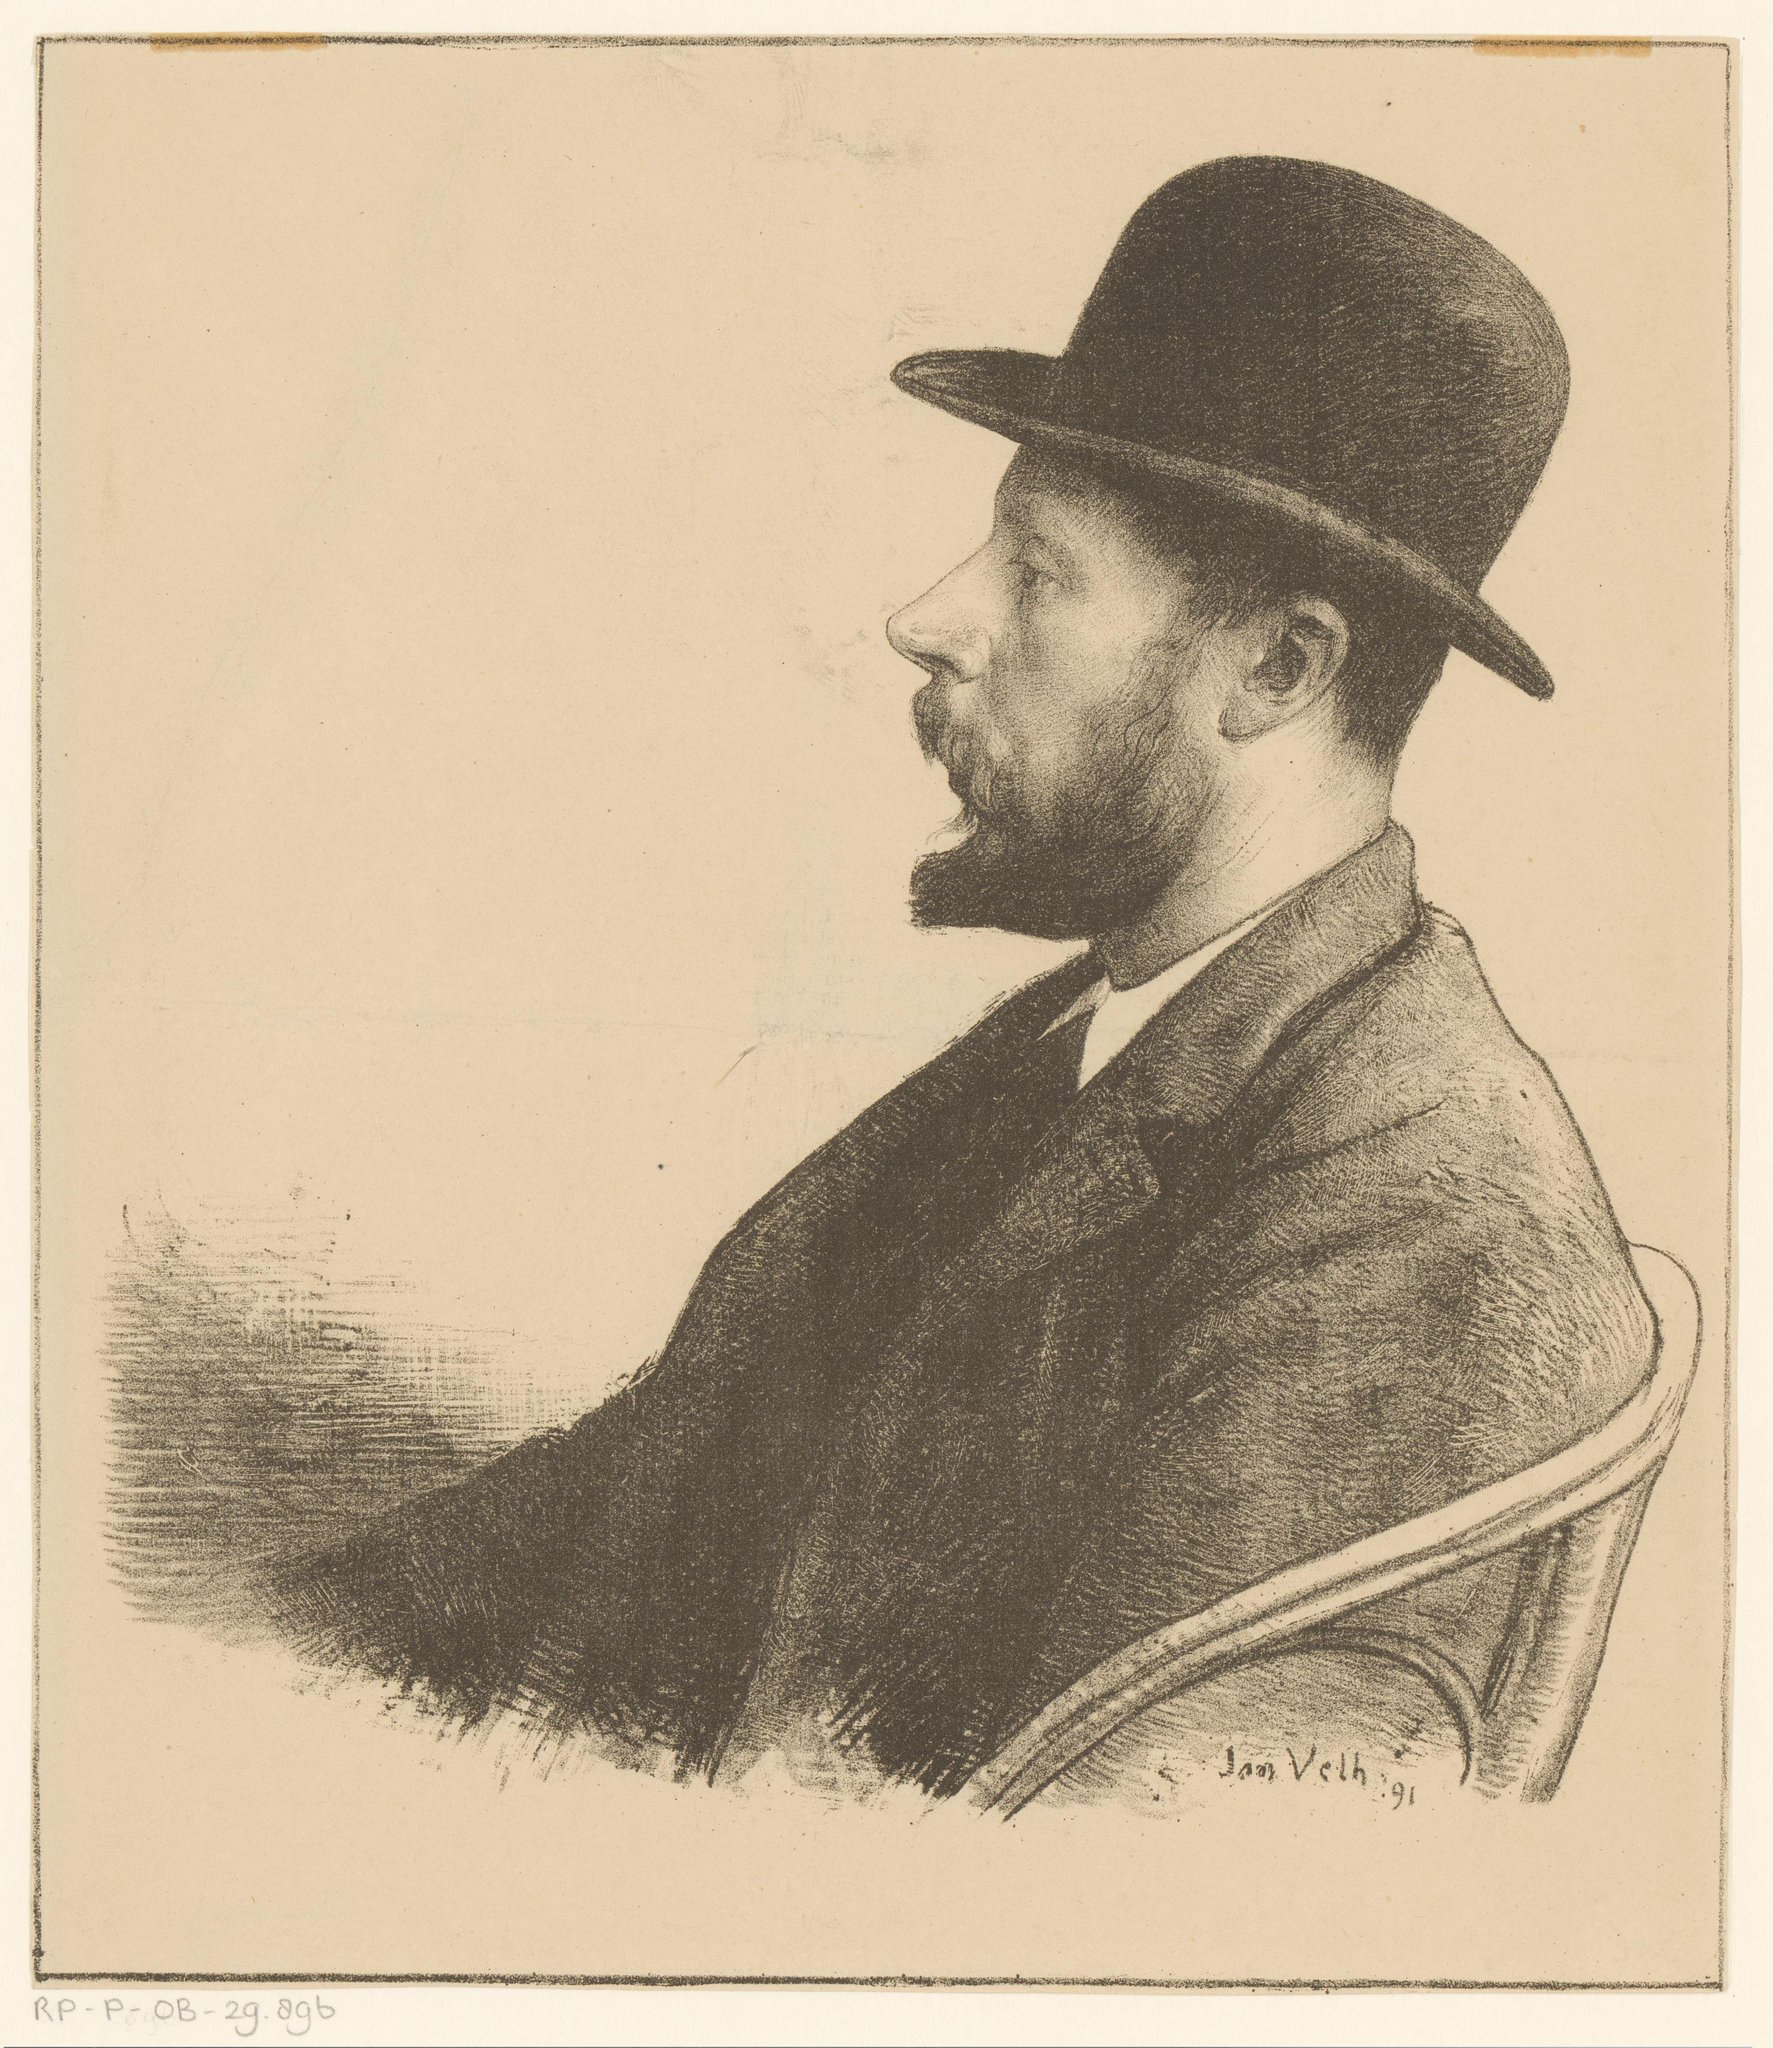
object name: print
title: Bekende tijdgenooten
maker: jan veth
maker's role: designer, draughtsman, painter, print maker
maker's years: 1864-1925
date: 1891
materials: paper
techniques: lithograph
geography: netherlands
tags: rotterdam, print maker, george hendrik breitner, historical persons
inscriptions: collector's mark: Lugt 2228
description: Deze prent werd uitgegeven als bijvoegsel van De Amsterdammer op 116 augustus 1891.